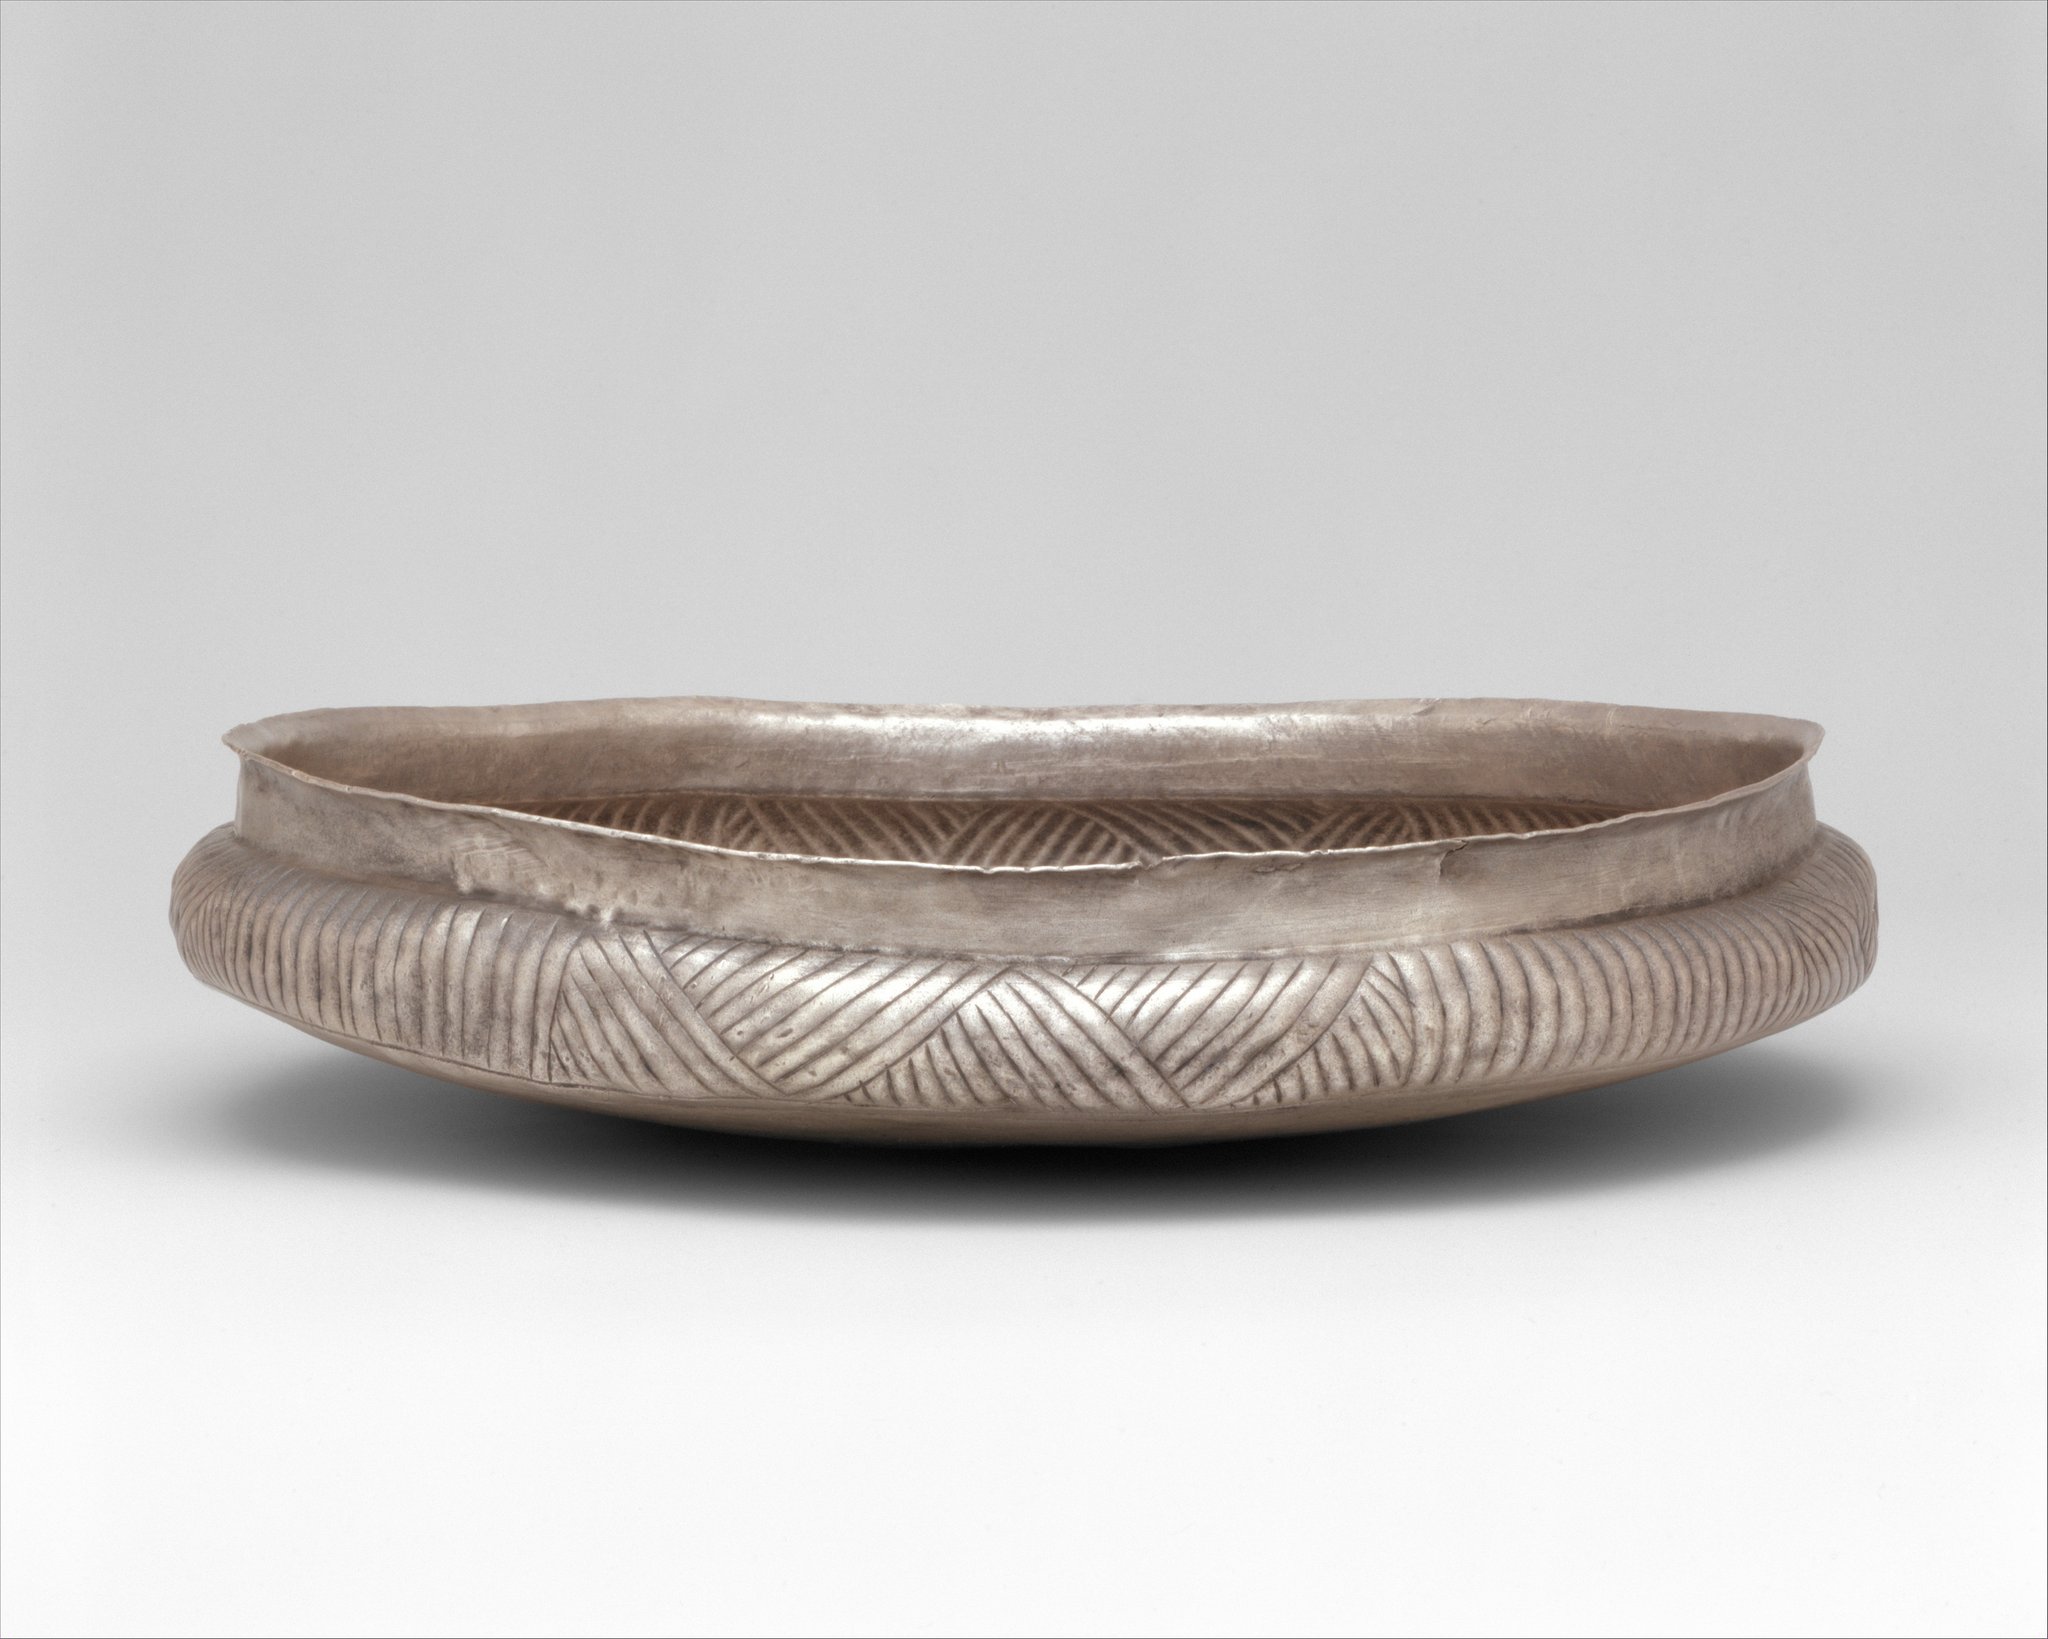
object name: bowl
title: Silver bowl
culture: cycladic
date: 3200-2200 BCE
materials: silver